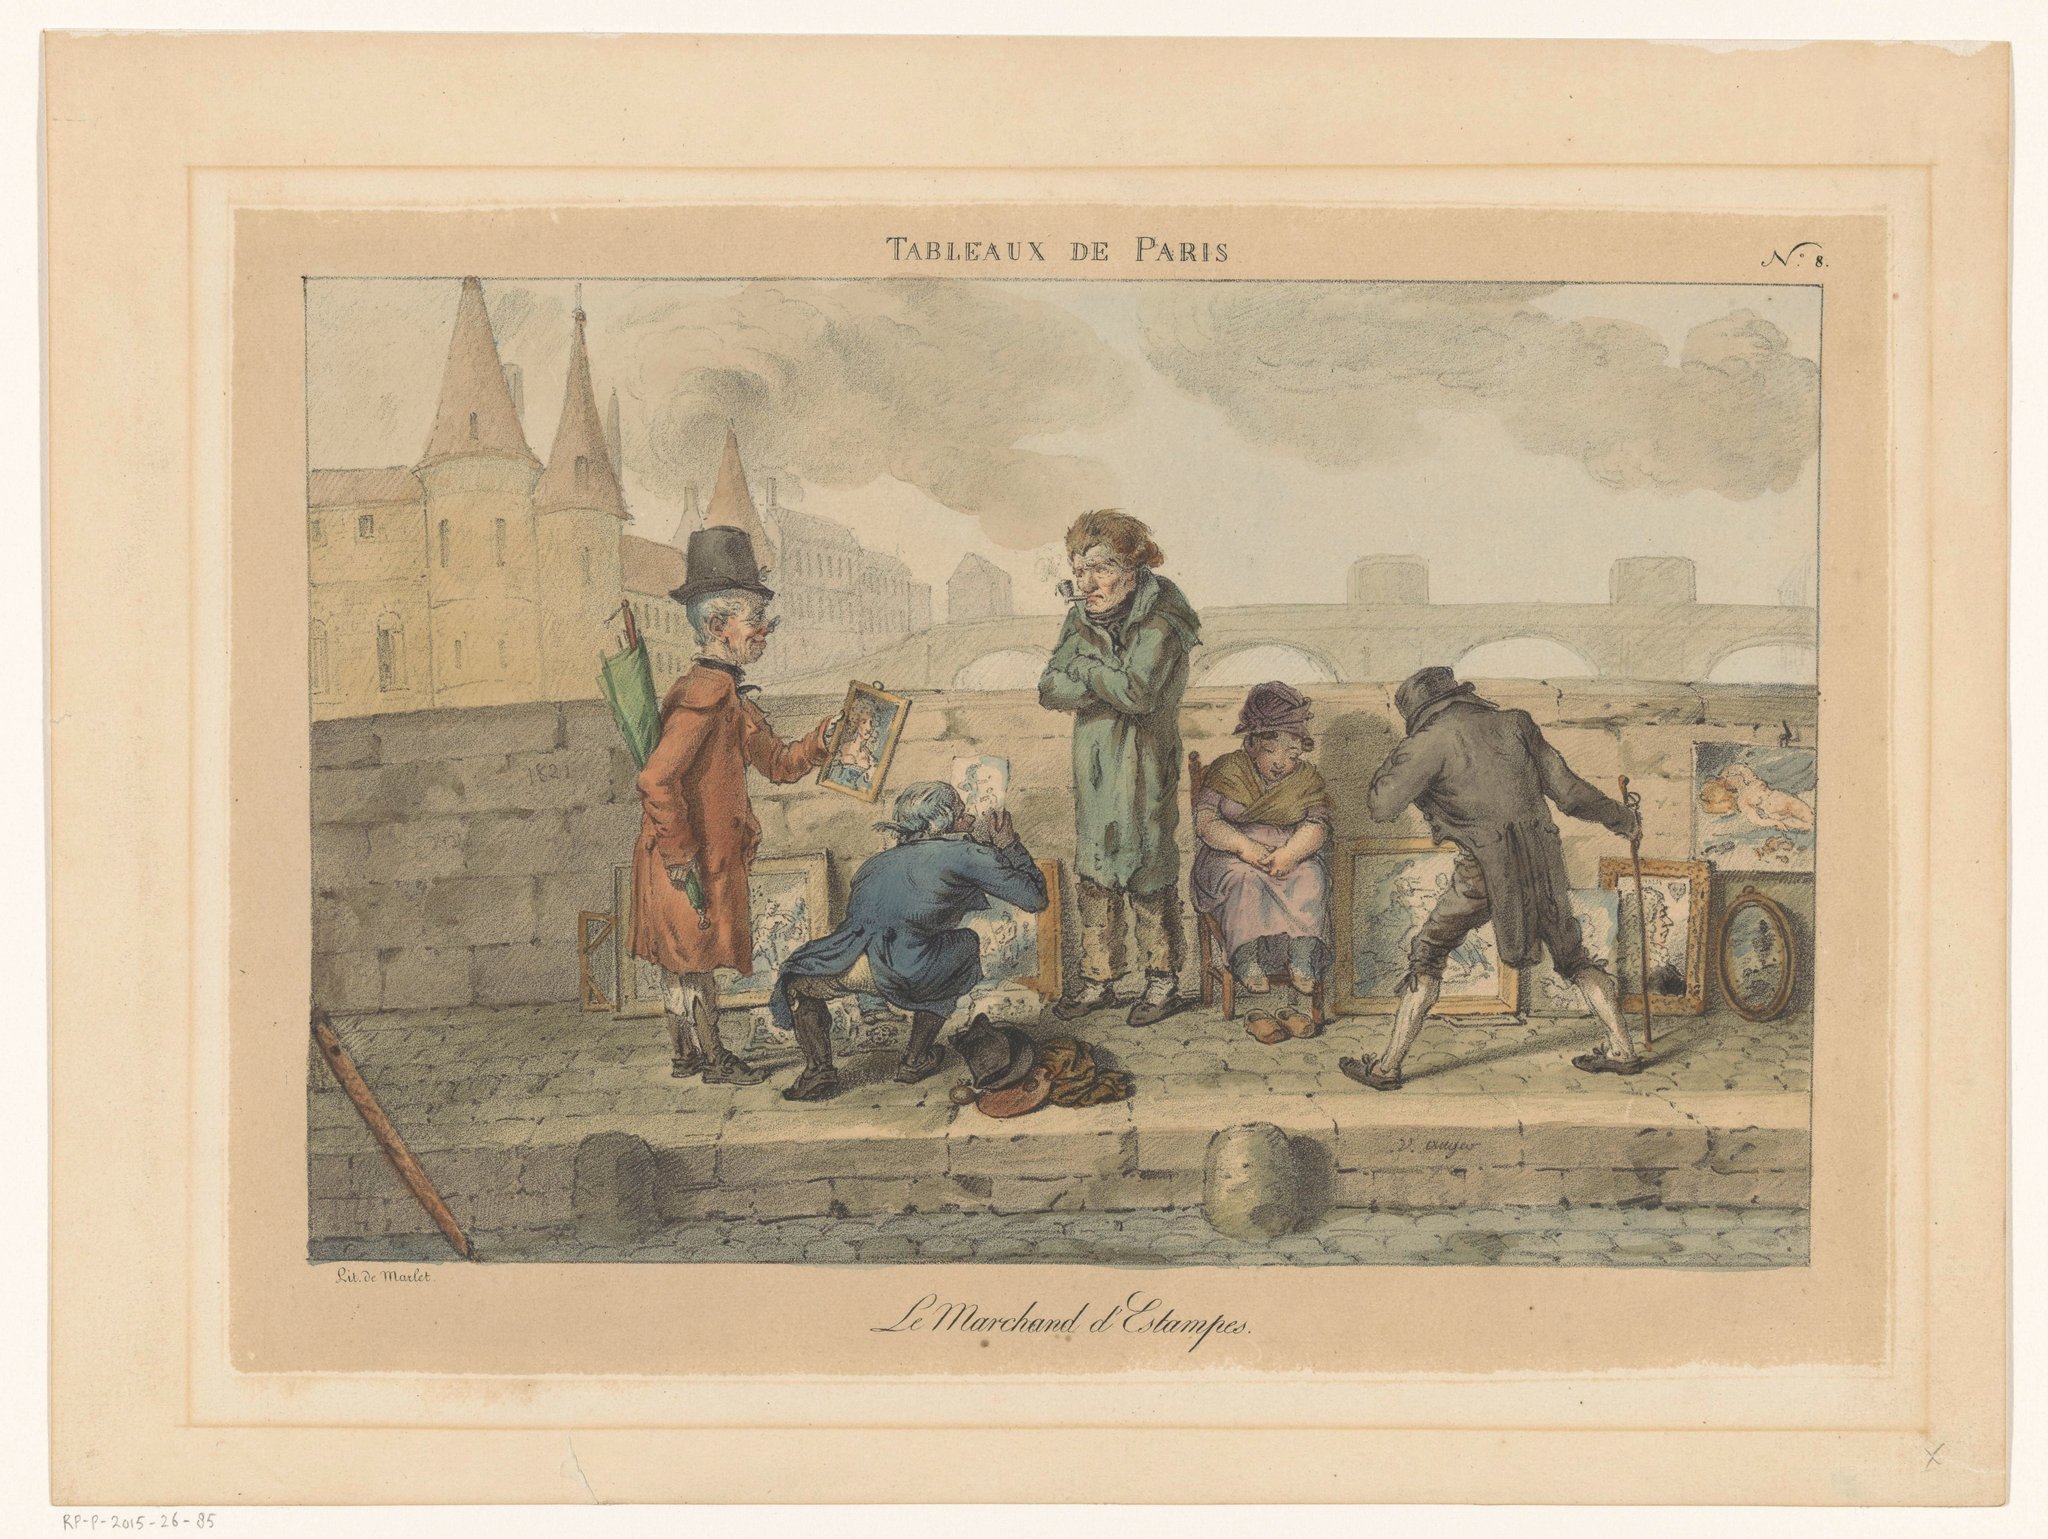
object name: print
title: Prentverkoper op een brug te Parijs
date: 1821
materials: paper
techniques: hand coloring, lithograph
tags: street-trader, paris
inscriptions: collector's mark: Lugt 4779, collector's mark: Lugt 4780, collector's mark: Lugt 2228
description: Een man en een vrouw verkopen prenten op een brug. Drie mannen bekijken het aanbod.